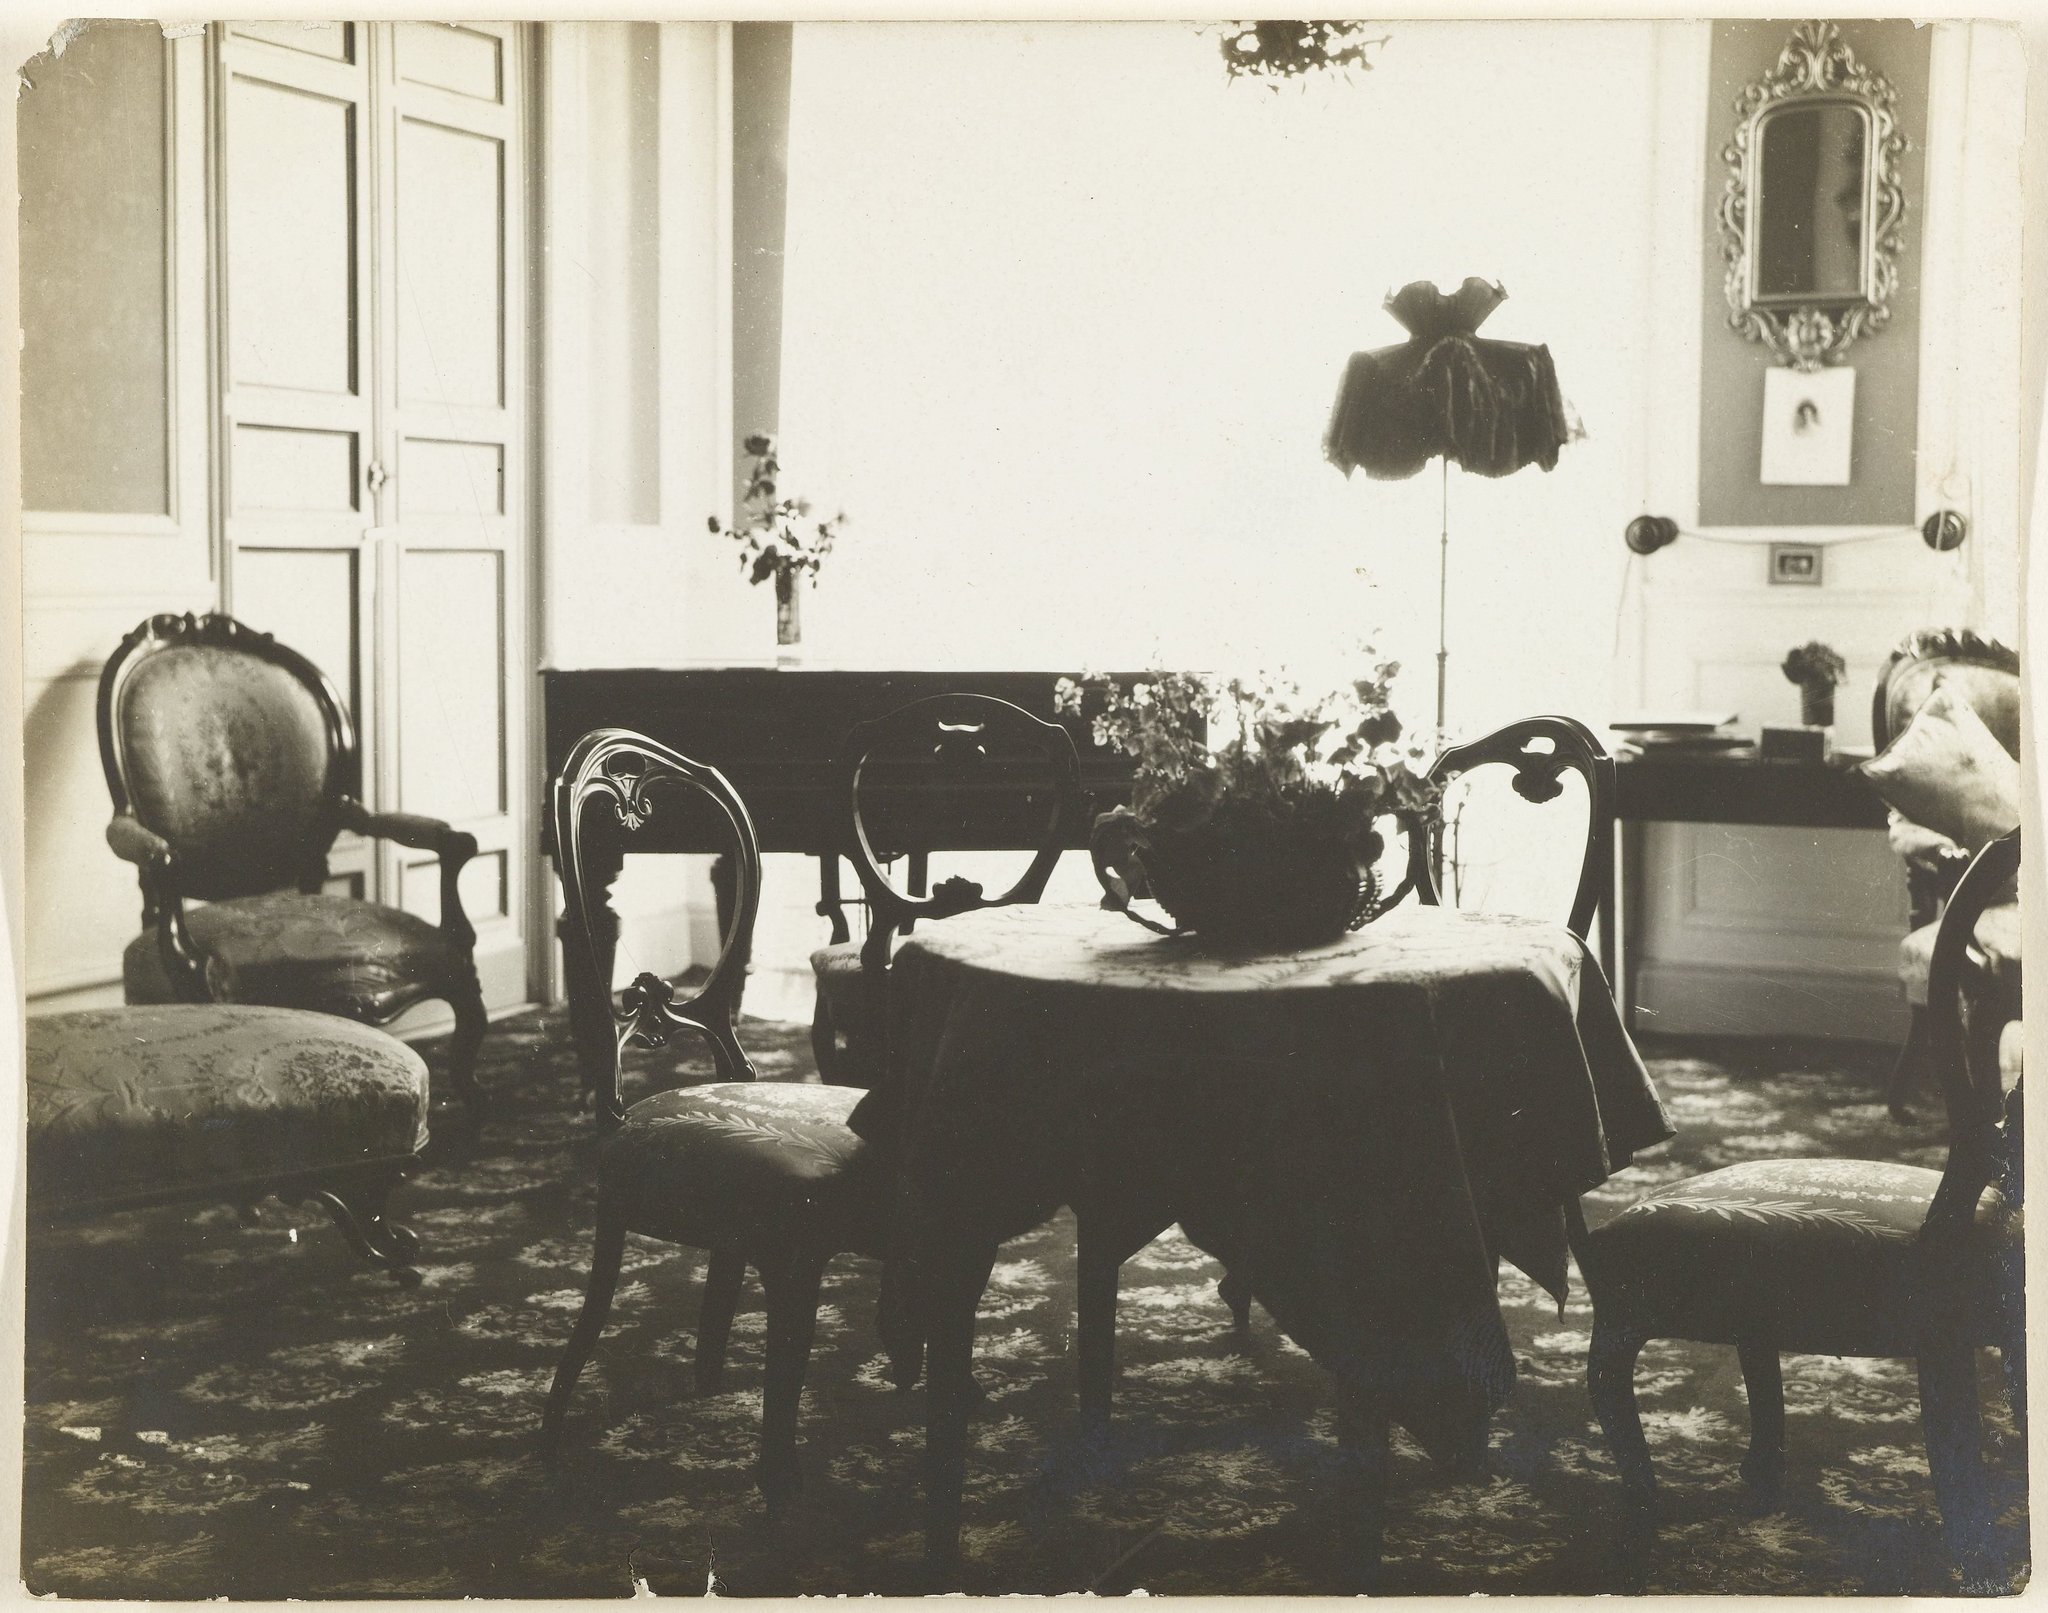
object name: photograph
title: Interieur van een salon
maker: Anonymous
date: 1915-1918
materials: paper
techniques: gelatin silver print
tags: communal rooms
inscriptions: inscription: ‘Salon unseres Hausses’